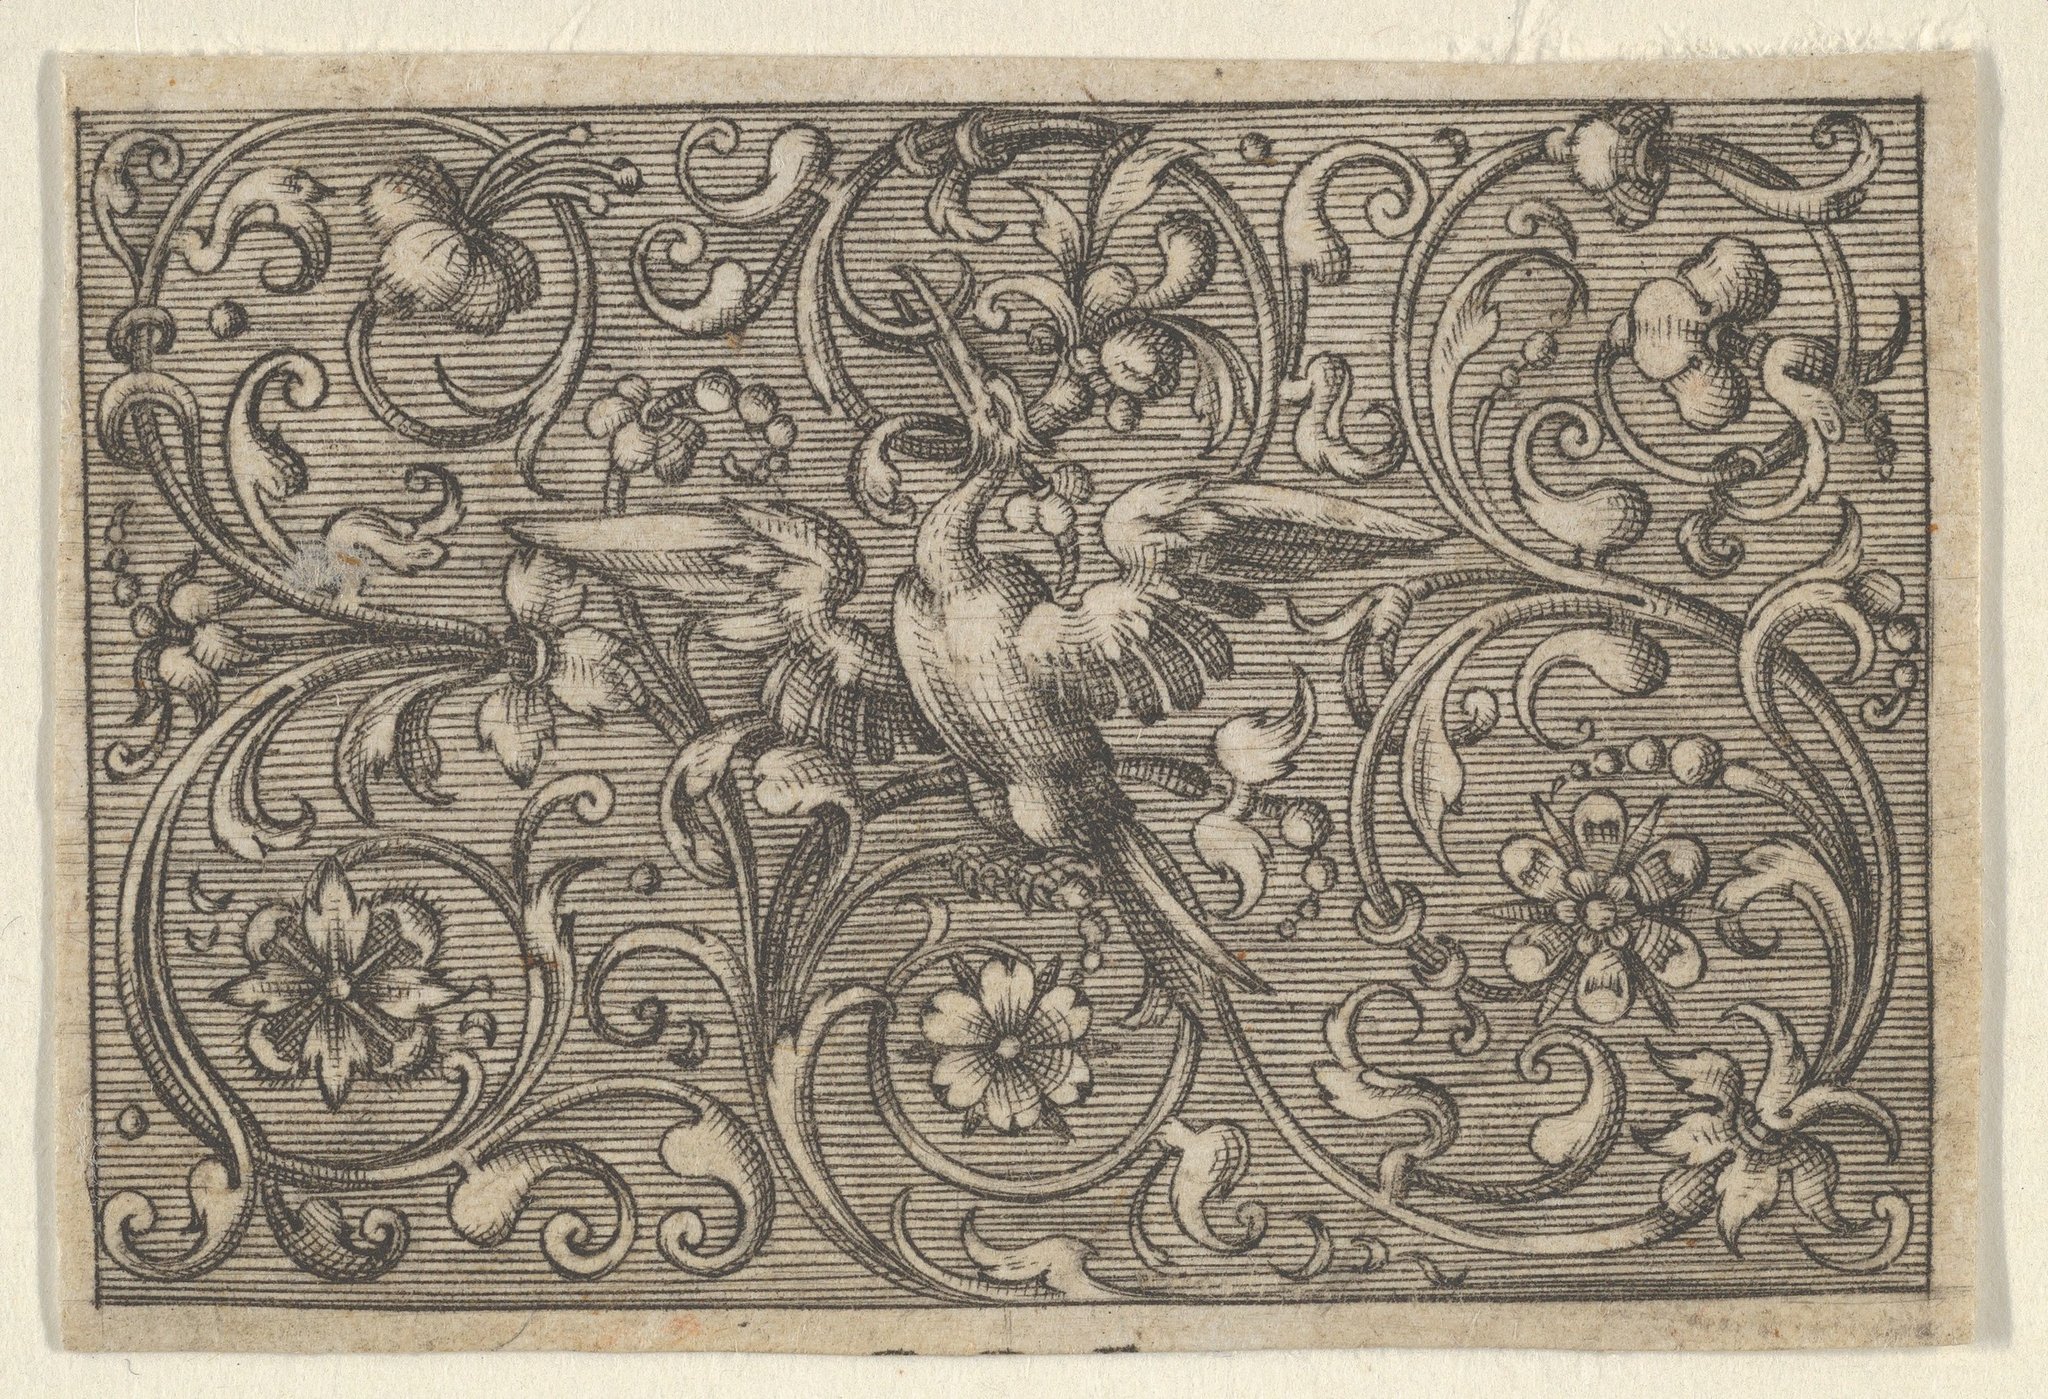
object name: print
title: Horizontal Panel with a Bird, from "Varii Generis Opera Aurifabris Necessaria"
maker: paul birckenhultz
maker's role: artist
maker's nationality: german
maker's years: 1561-1639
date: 1600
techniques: engraving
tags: birds,flowers